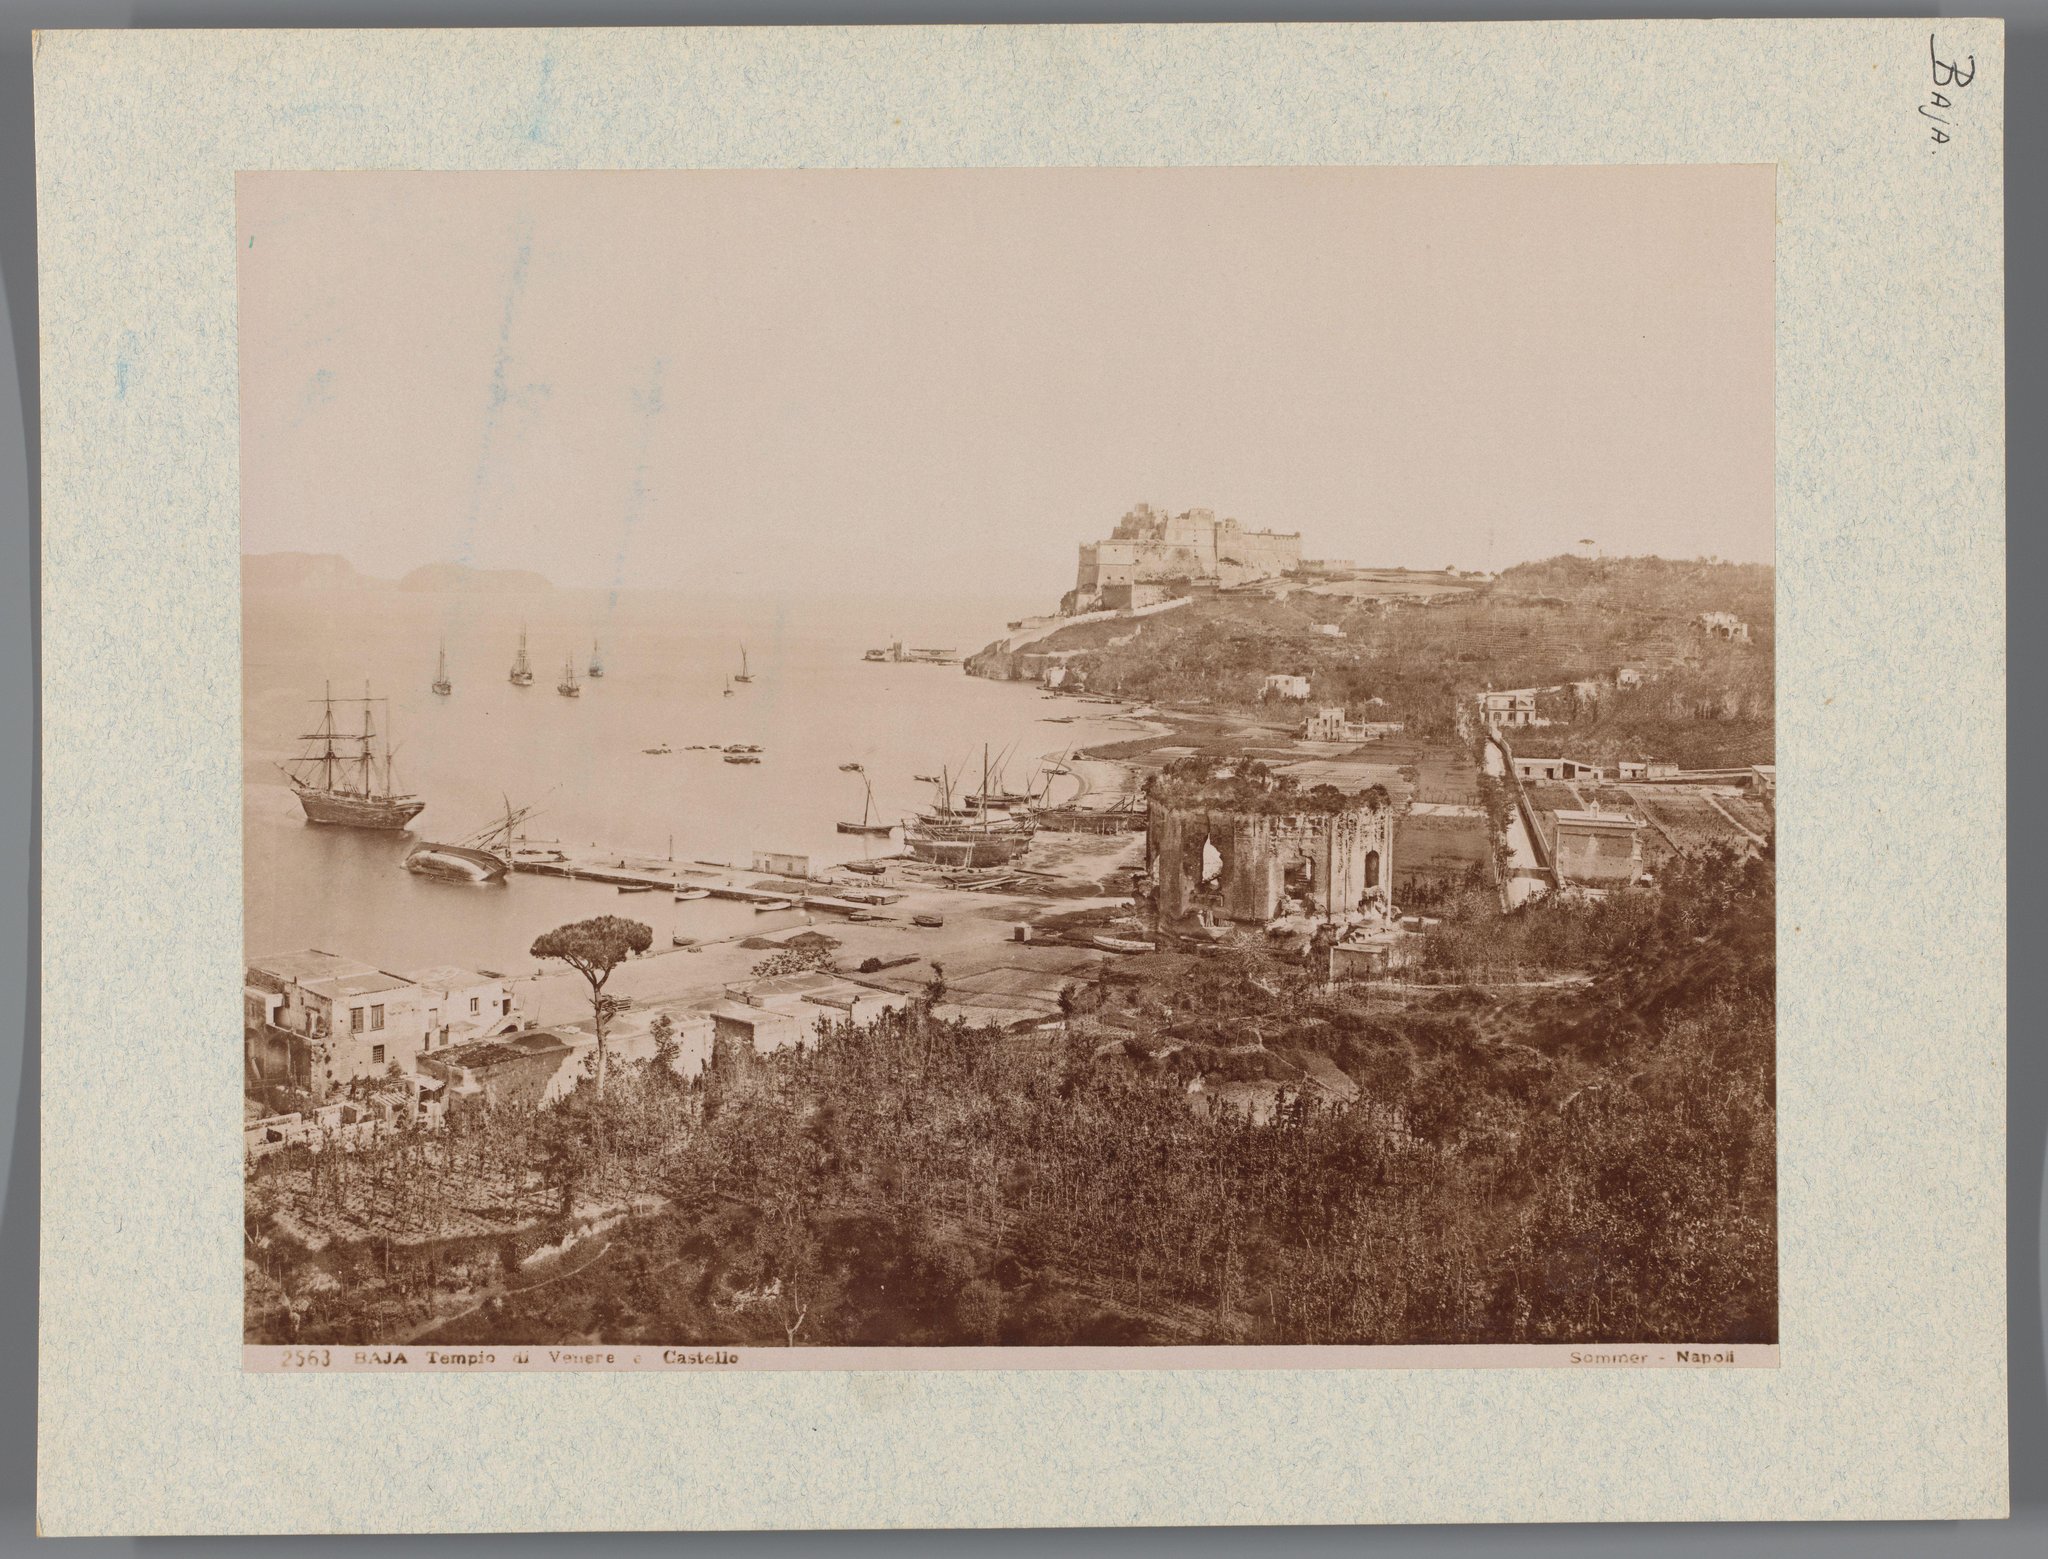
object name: photograph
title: Italië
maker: Anonymous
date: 1880-1910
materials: photographic support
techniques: albumen print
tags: italy